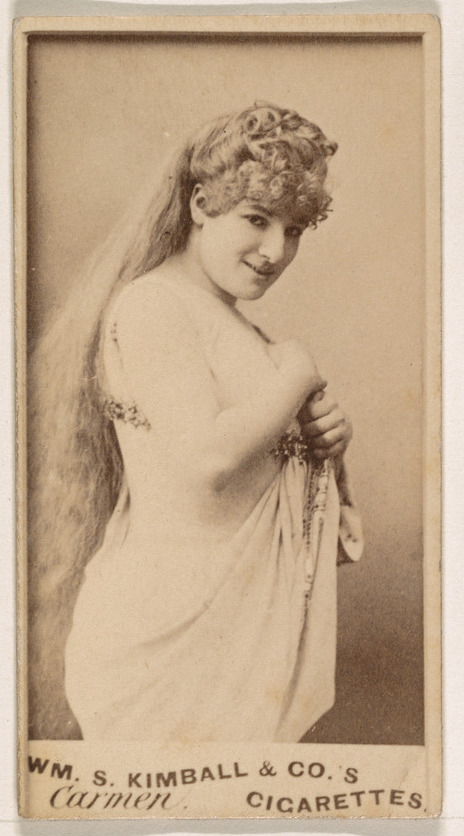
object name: photograph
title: Miss Carmen, from the Actresses series (N203) issued by Wm. S. Kimball & Co.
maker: william s. kimball & company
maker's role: publisher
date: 1889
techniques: color lithograph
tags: portraits,women,actresses